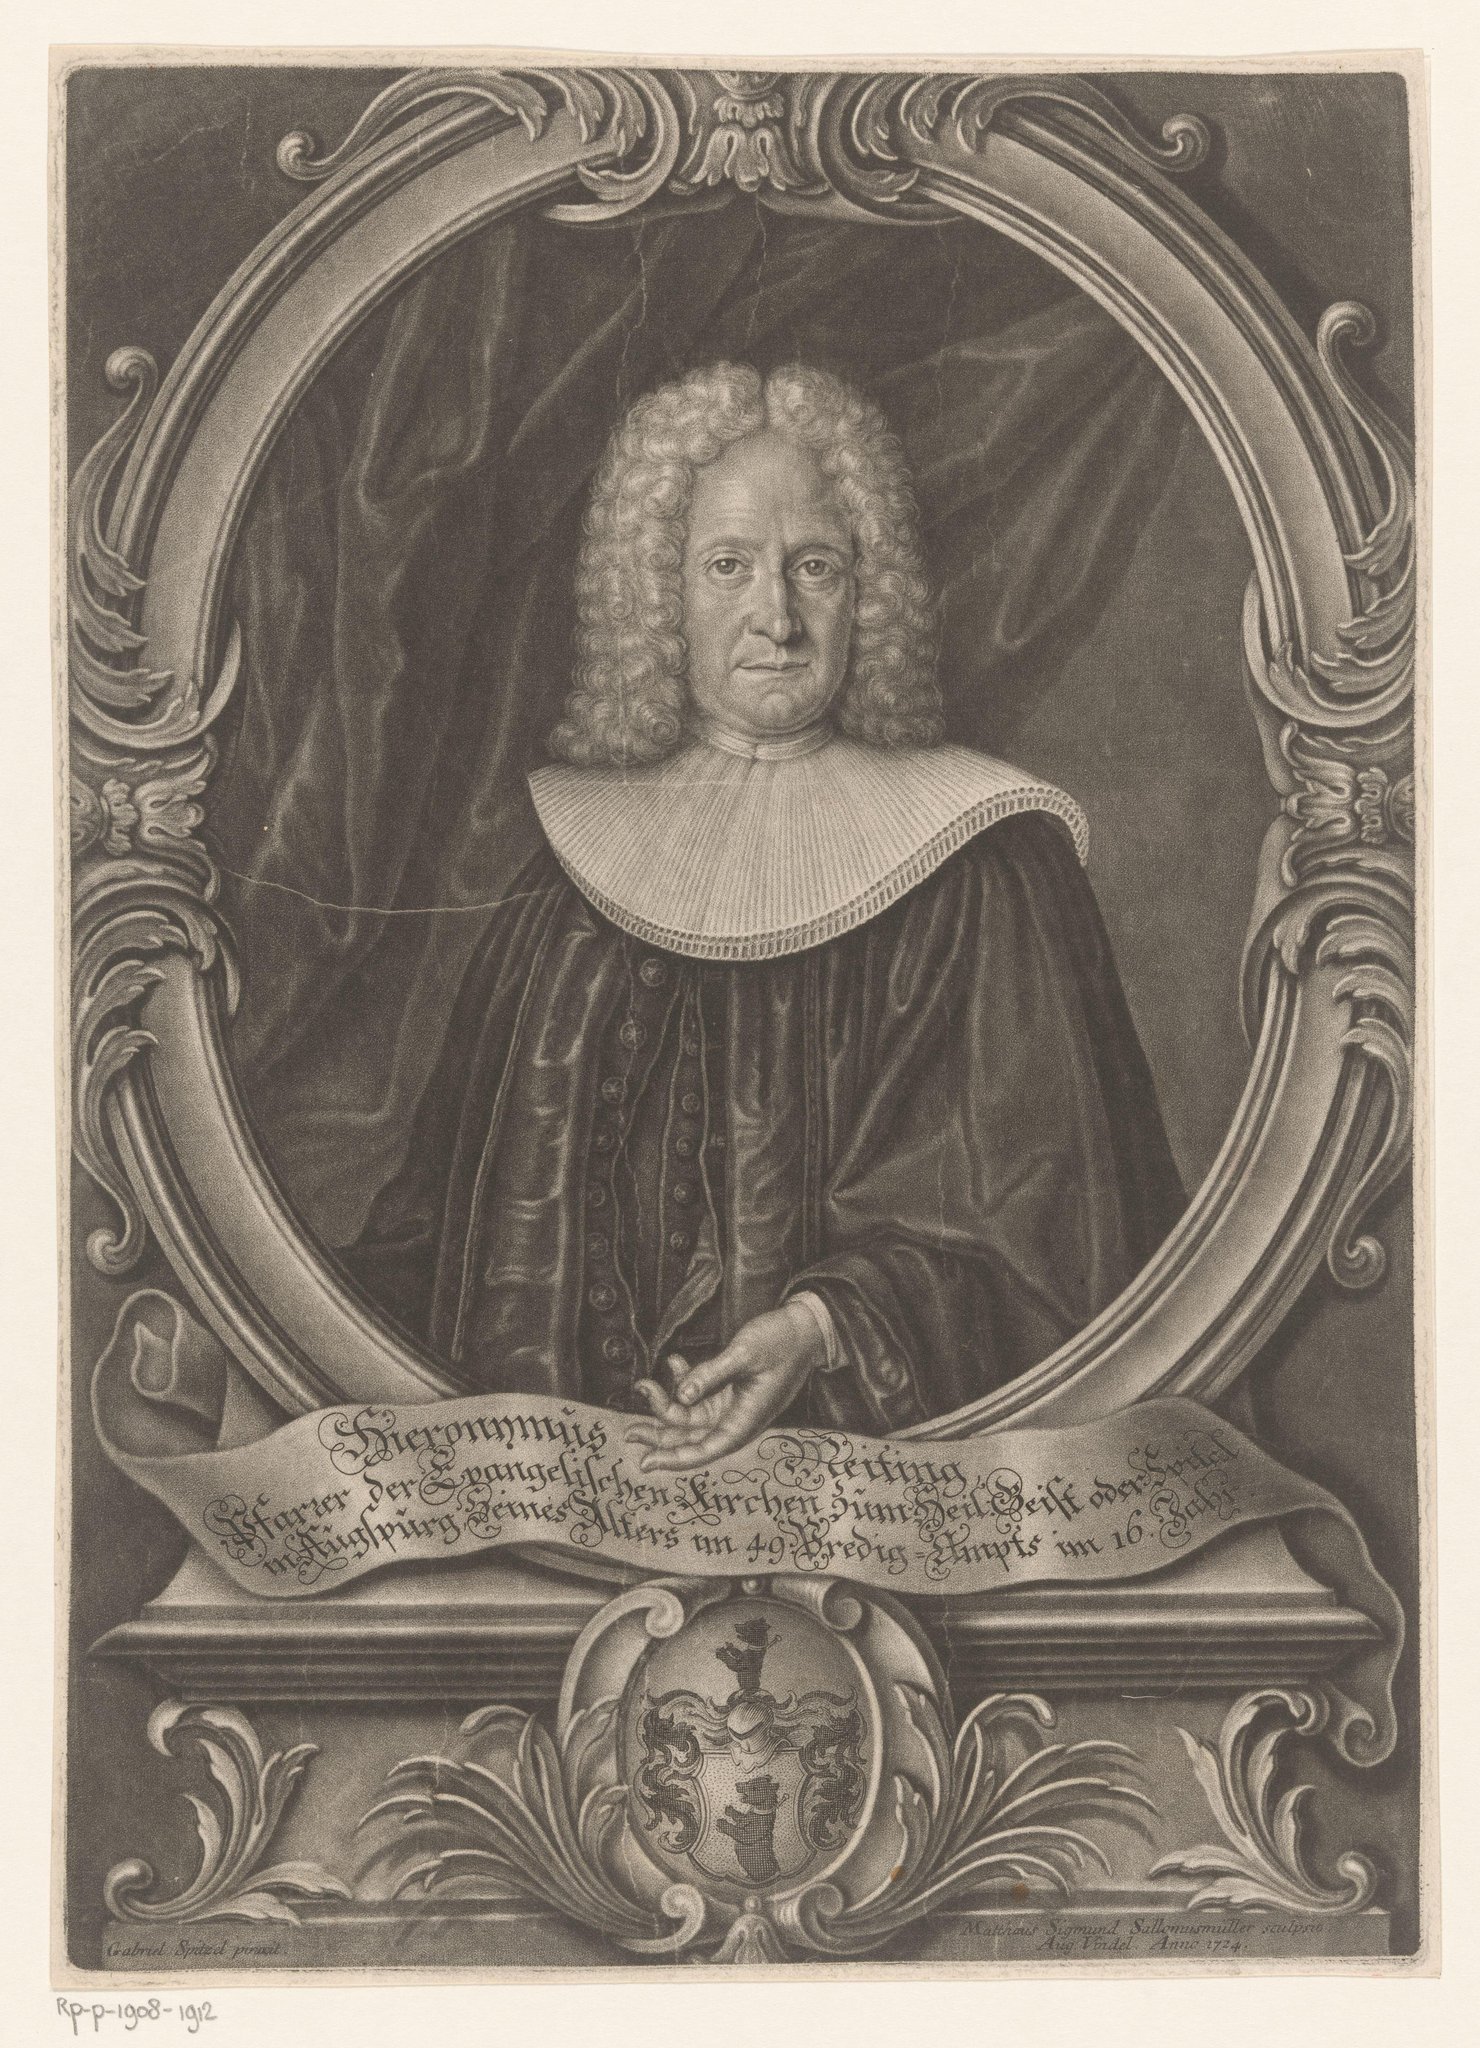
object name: print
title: Portret van Hieronymus Meiting op 49-jarige leeftijd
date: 1724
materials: paper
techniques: etching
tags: augsburg, theologian, historical persons, armorial bearing, heraldry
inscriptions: collector's mark: Lugt 2228